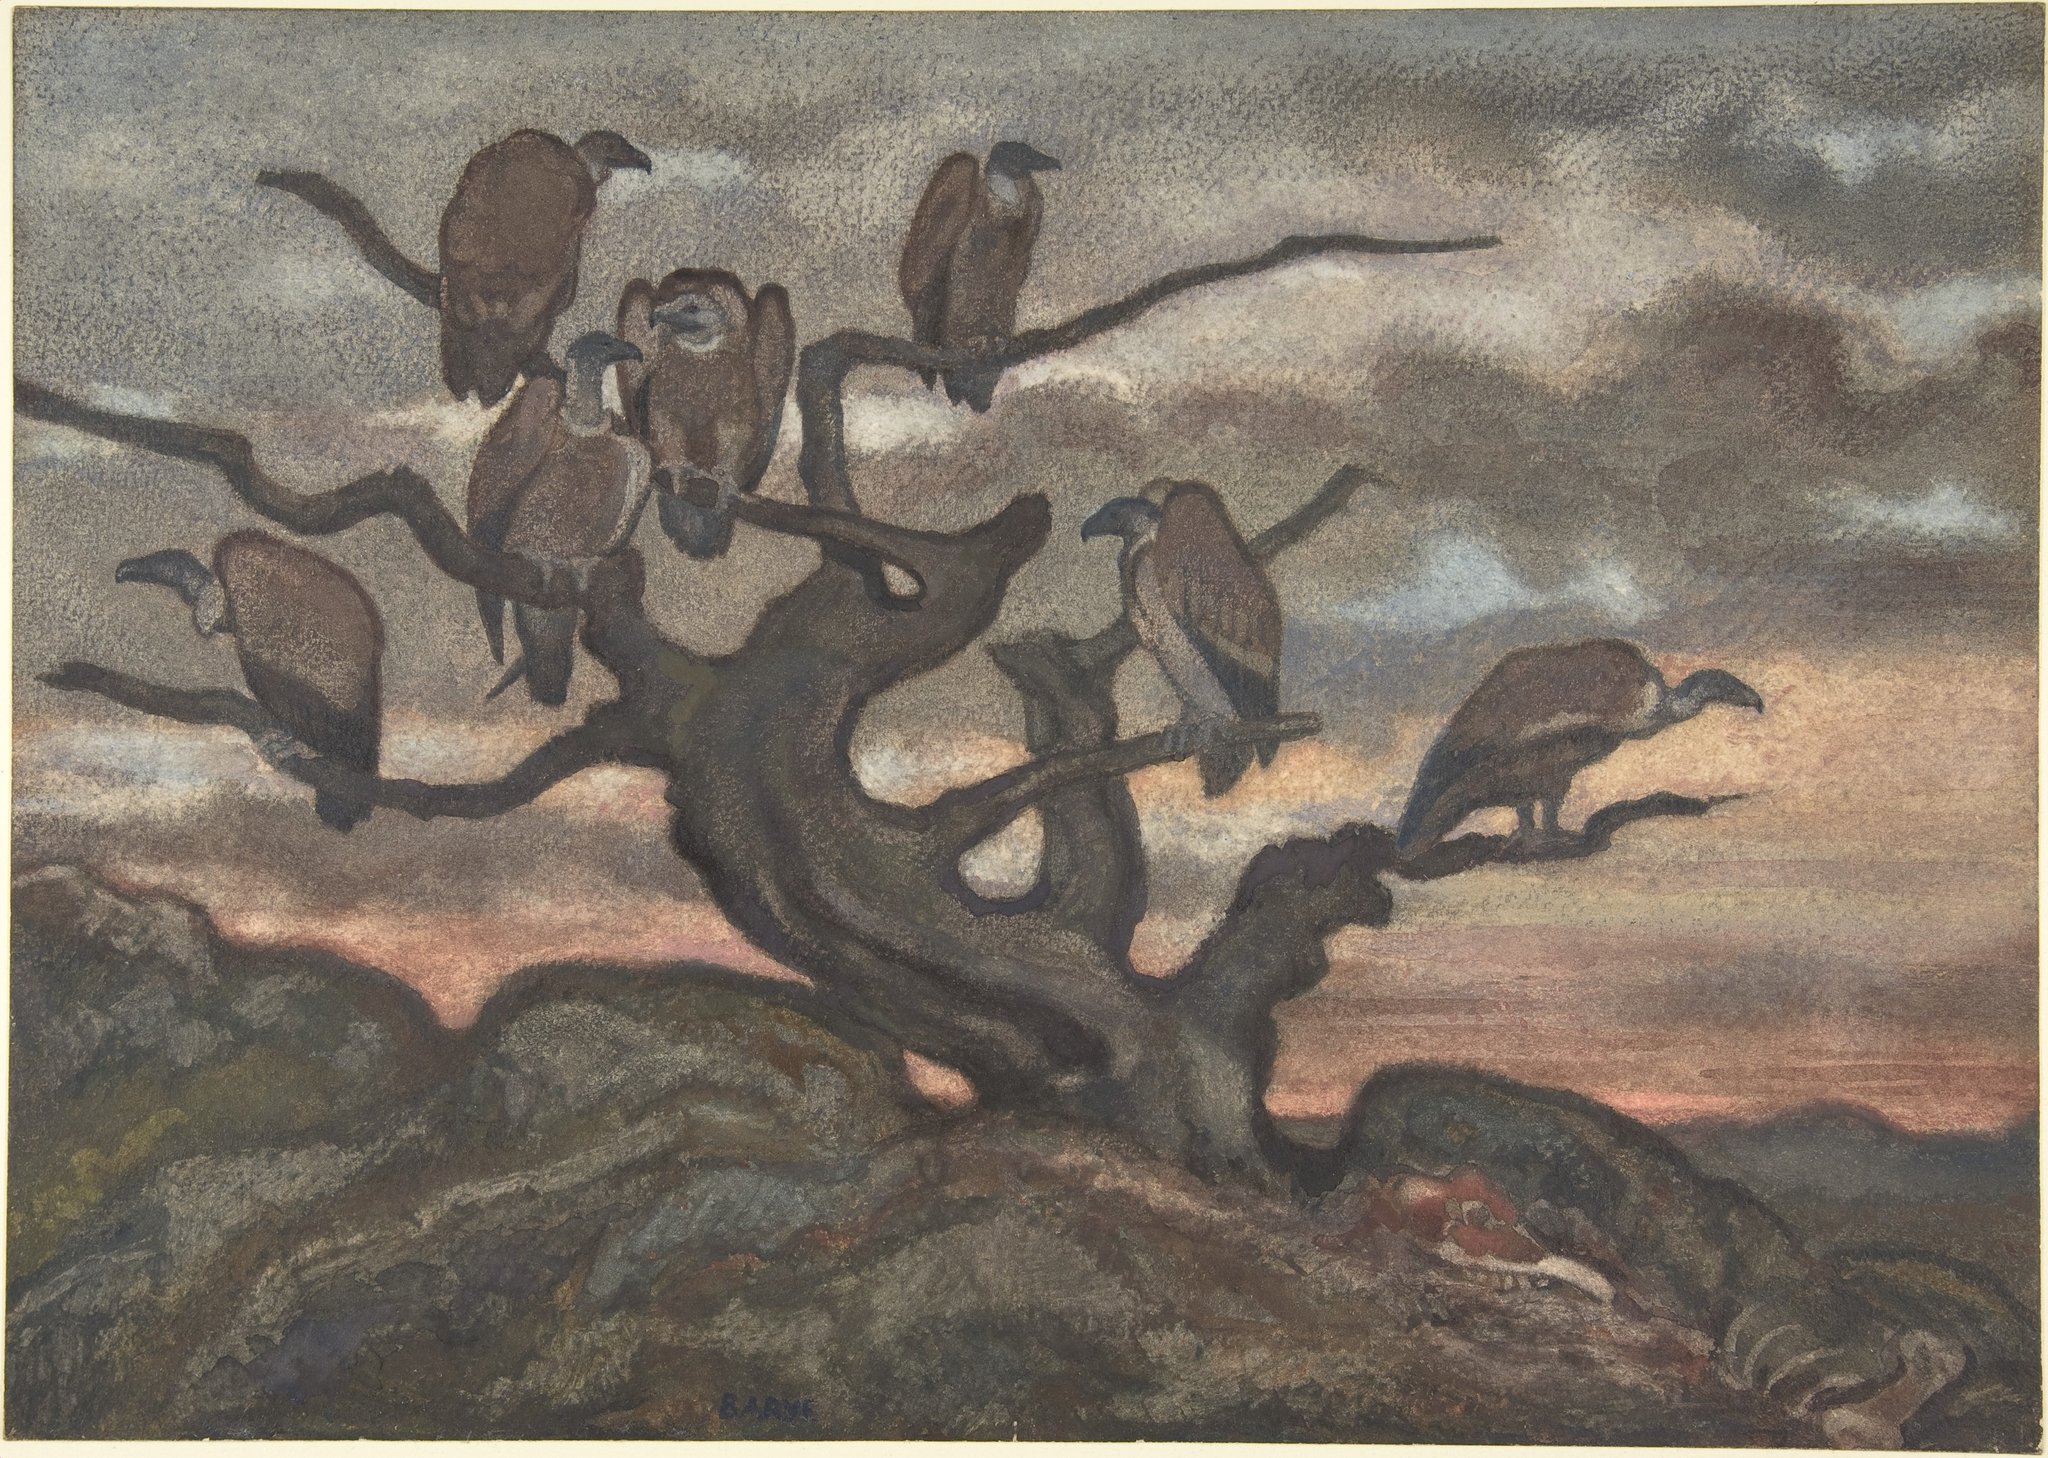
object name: drawing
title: Vultures on a Tree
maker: antoine-louis barye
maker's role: artist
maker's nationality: french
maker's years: 1795-1875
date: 1810-1875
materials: watercolor, paper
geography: france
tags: birds,trees